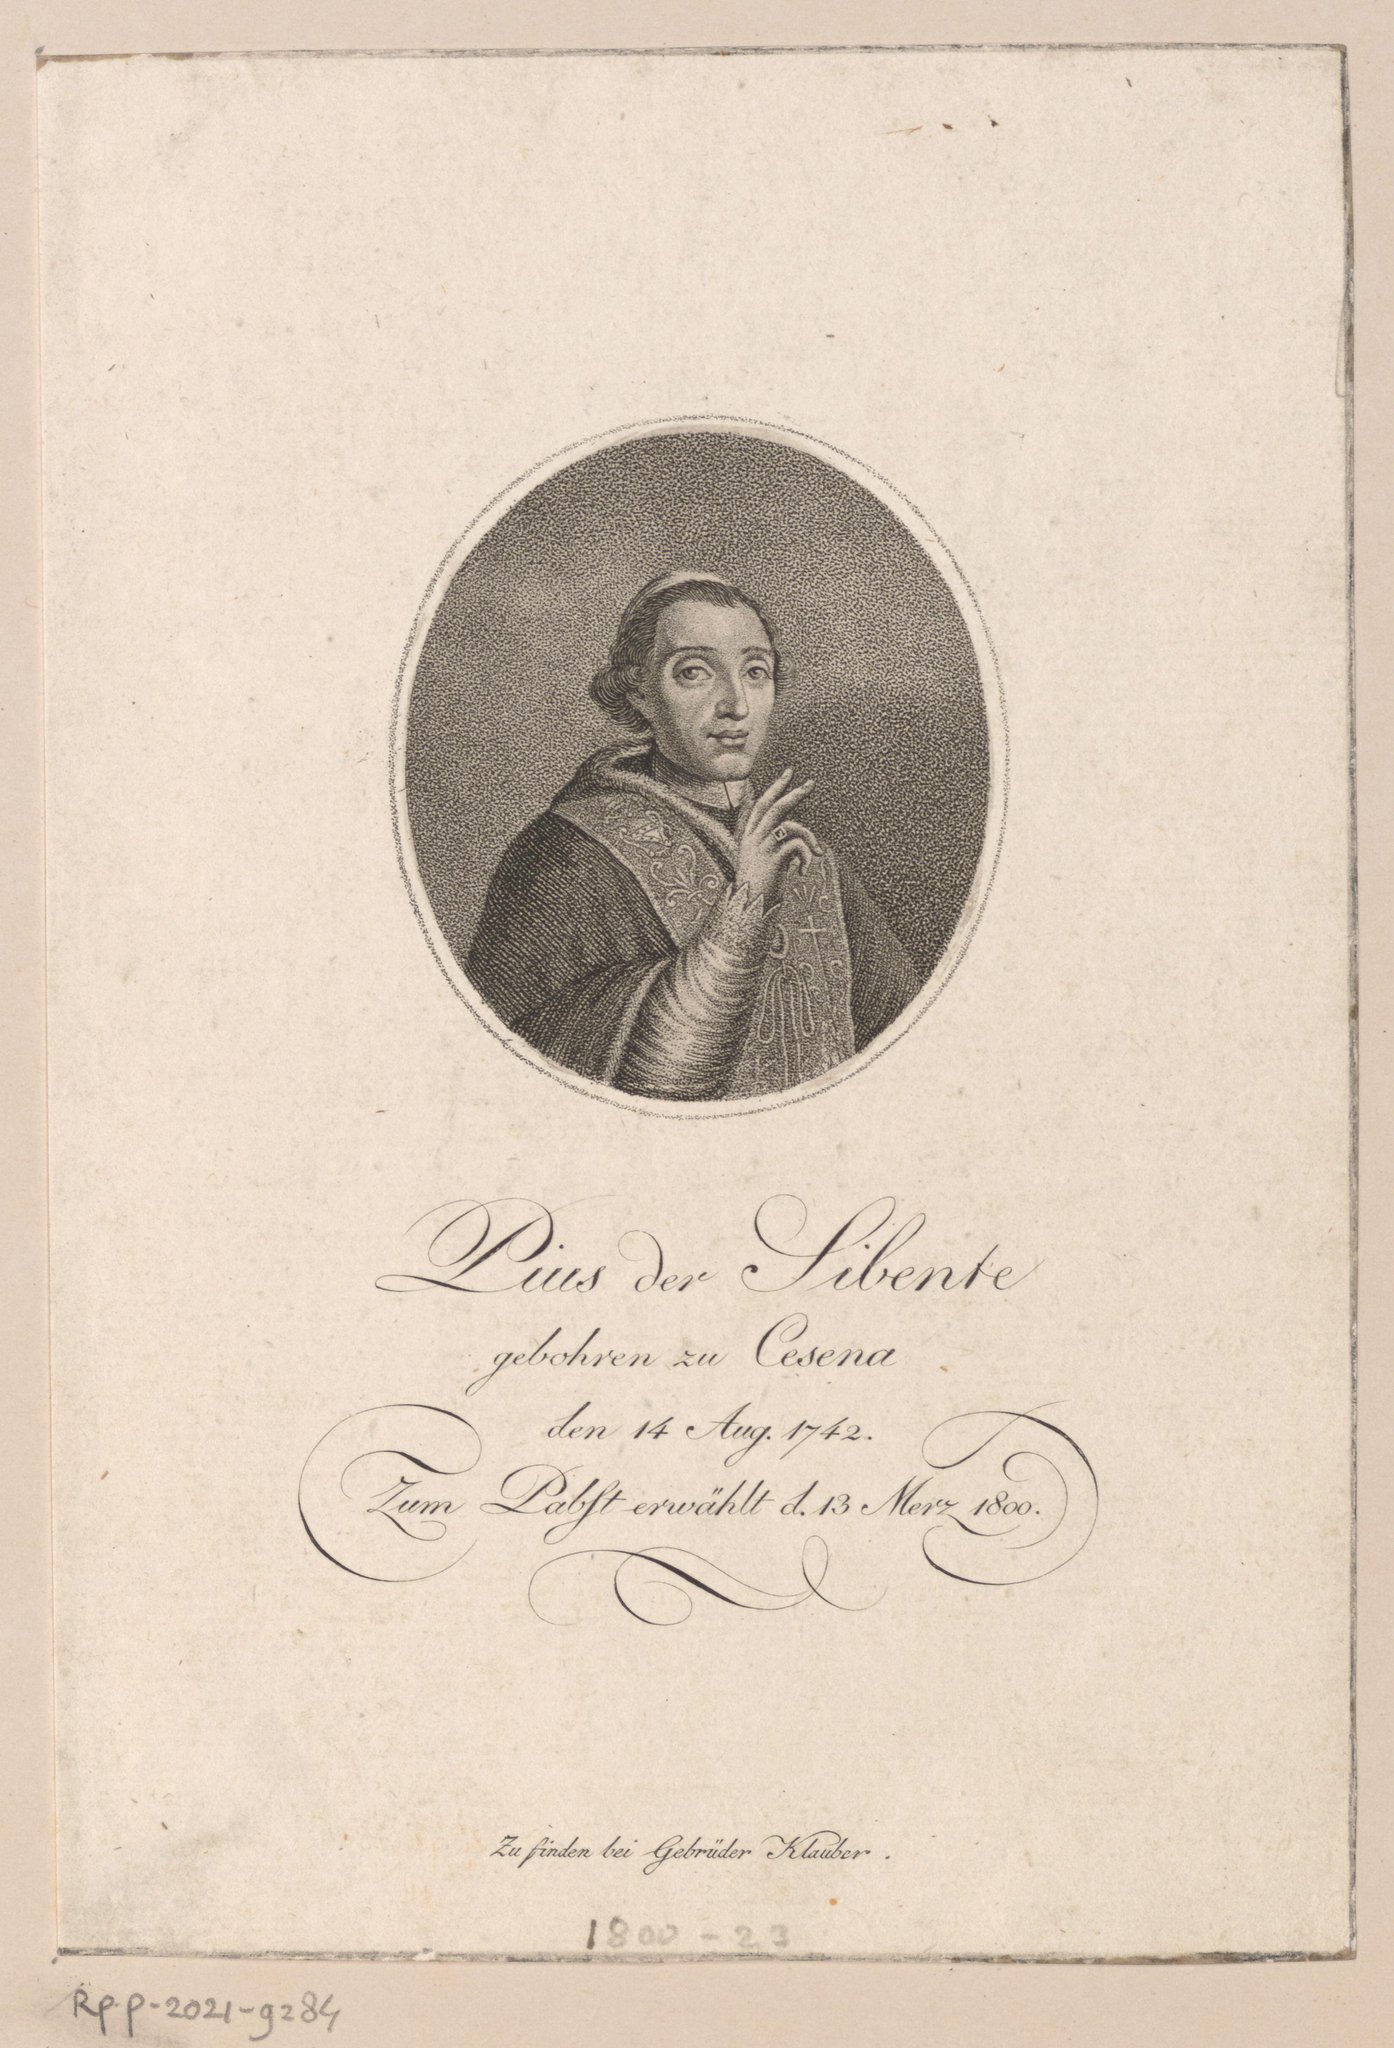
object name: print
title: Portret van paus Pius VII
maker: Anonymous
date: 1800-1837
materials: paper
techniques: engraving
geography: augsburg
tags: rome, clergyman, pius vii, historical persons, pope